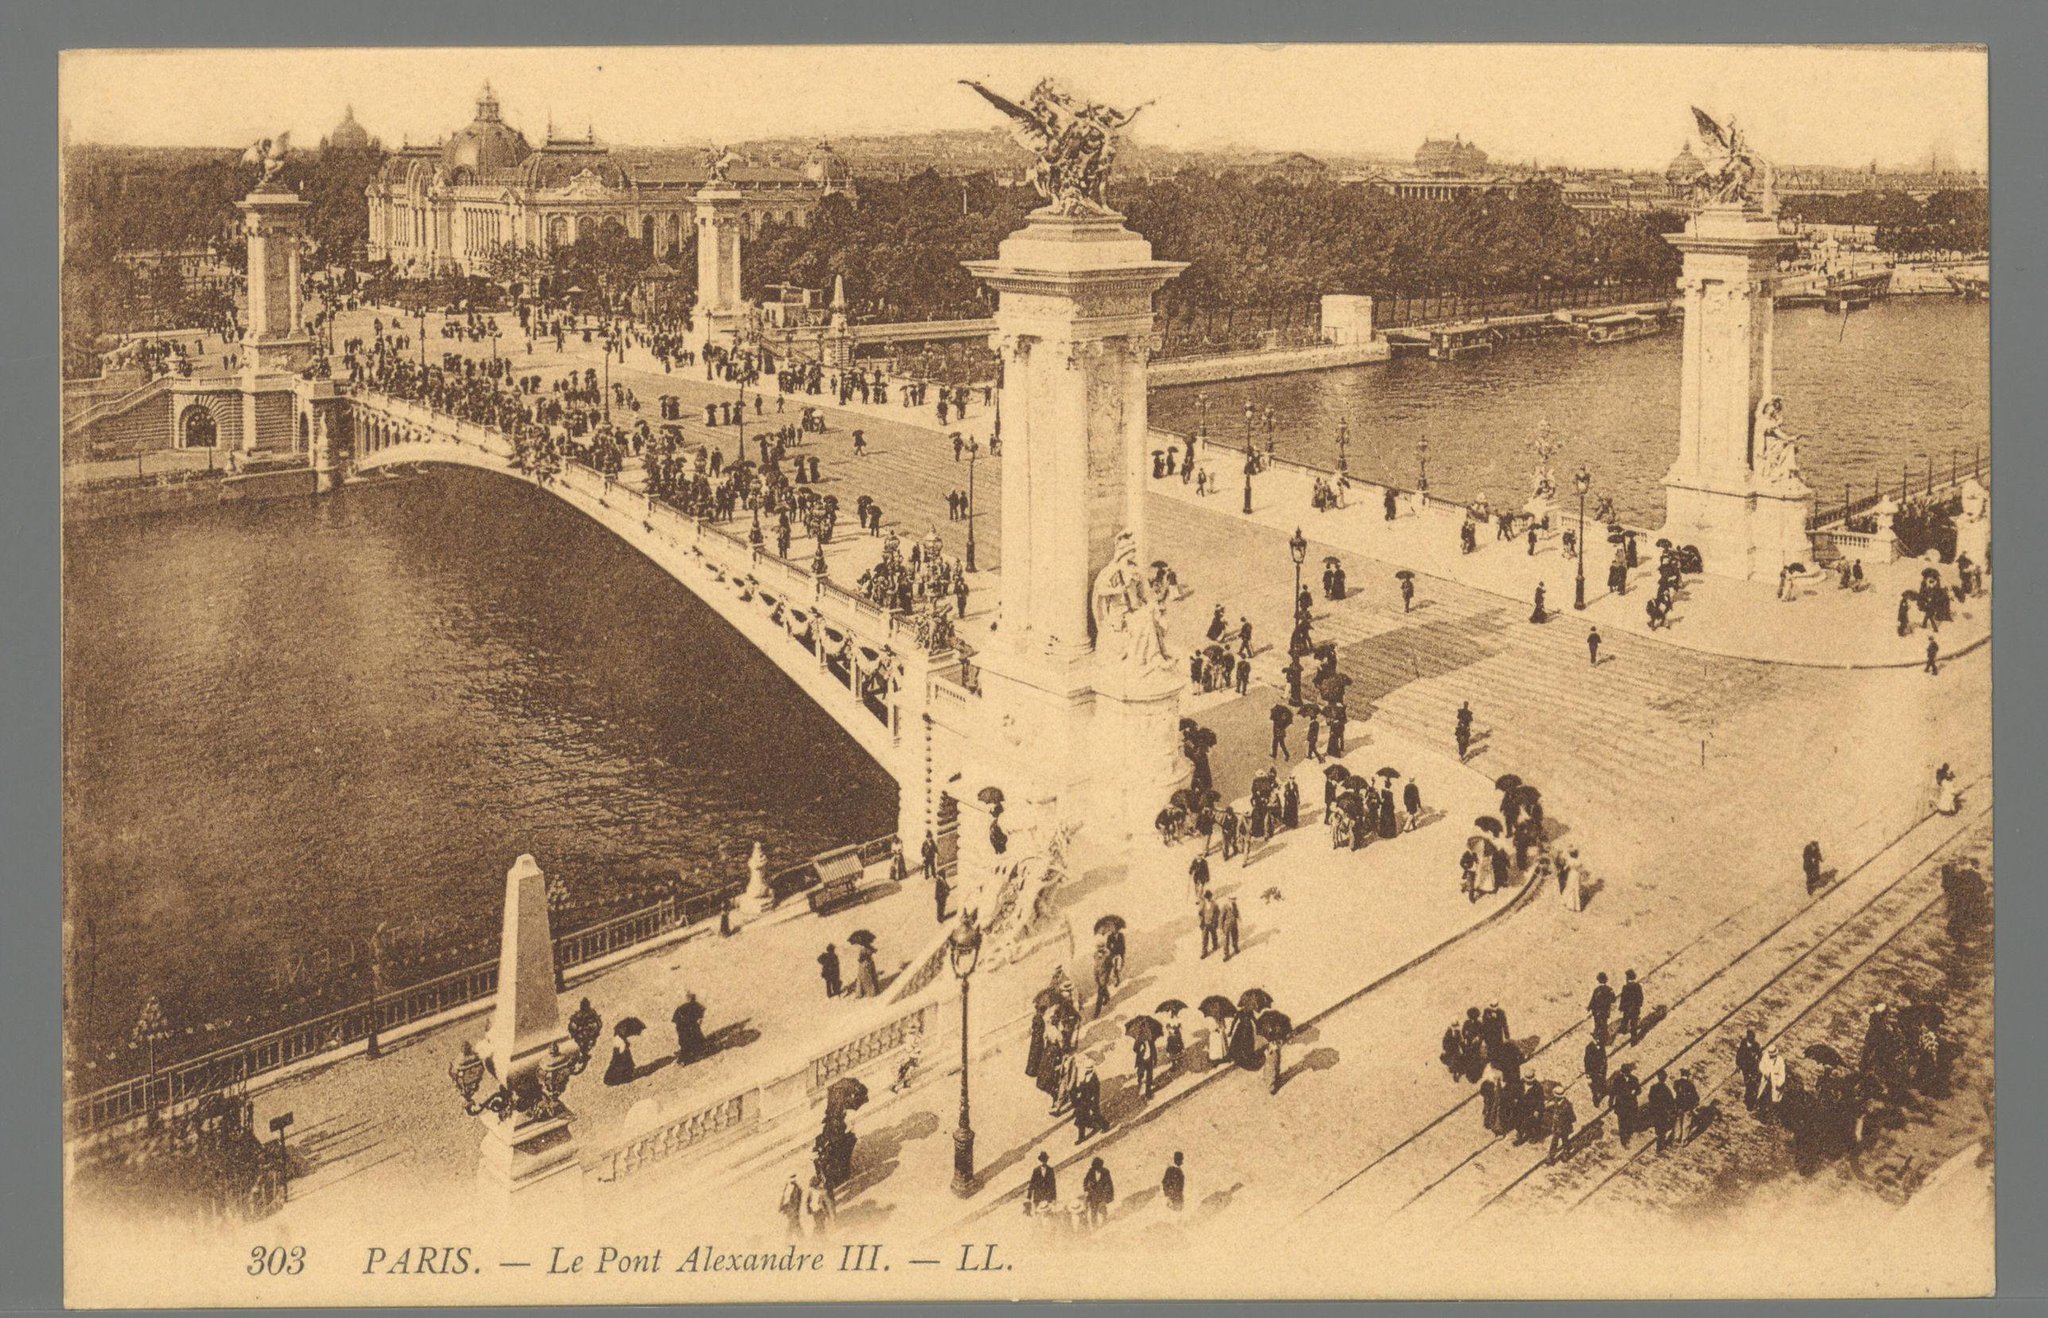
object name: photomechanical print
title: Paris. Le Pont Alexandre III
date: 1904-1906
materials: cardboard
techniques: photograph, writing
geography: paris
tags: river, bridge, city-view, and landscape with man-made constructions (+ city(-scape) with figures, staffage)